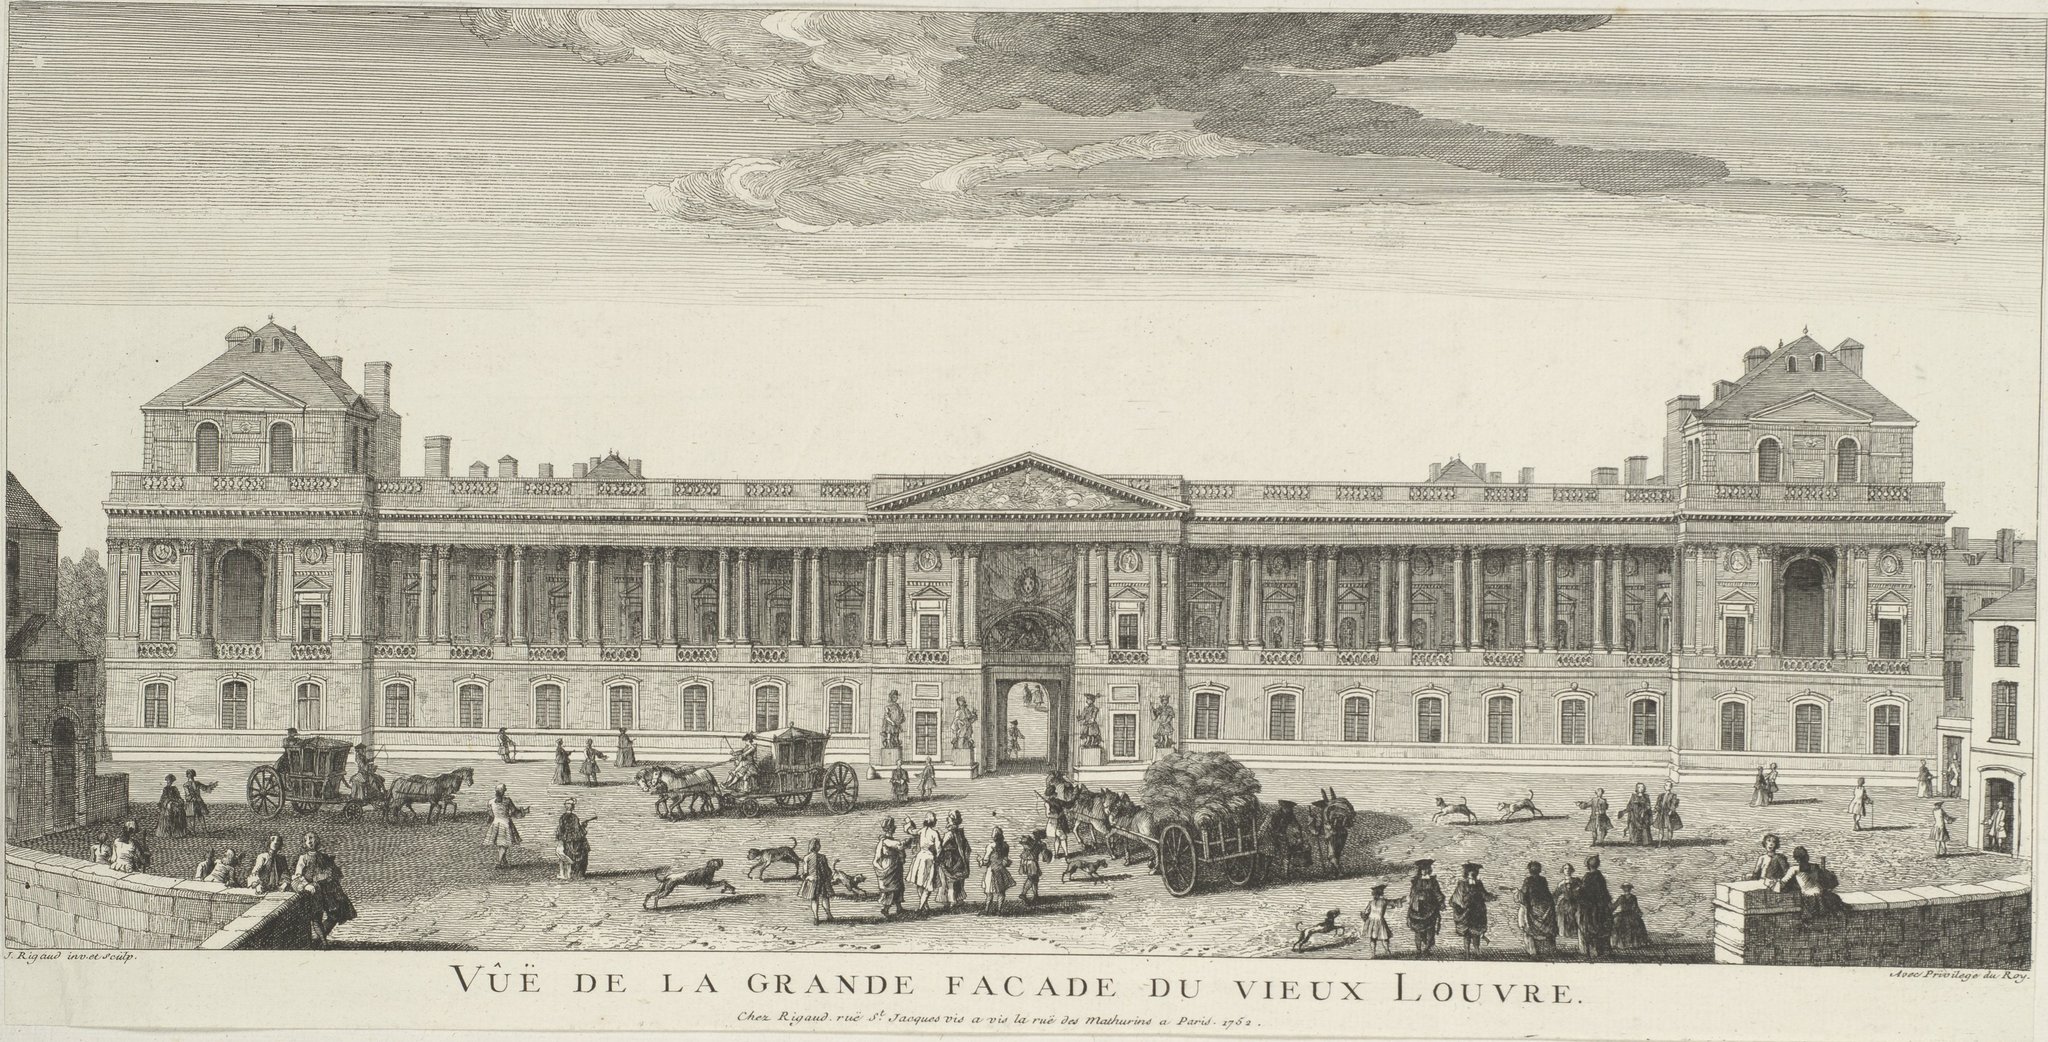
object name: print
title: Vue de la Grande Façade du Vieux Louvre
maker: jacques rigaud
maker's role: artist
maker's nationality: french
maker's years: 1681-1754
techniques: etching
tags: architecture,palaces,carriages